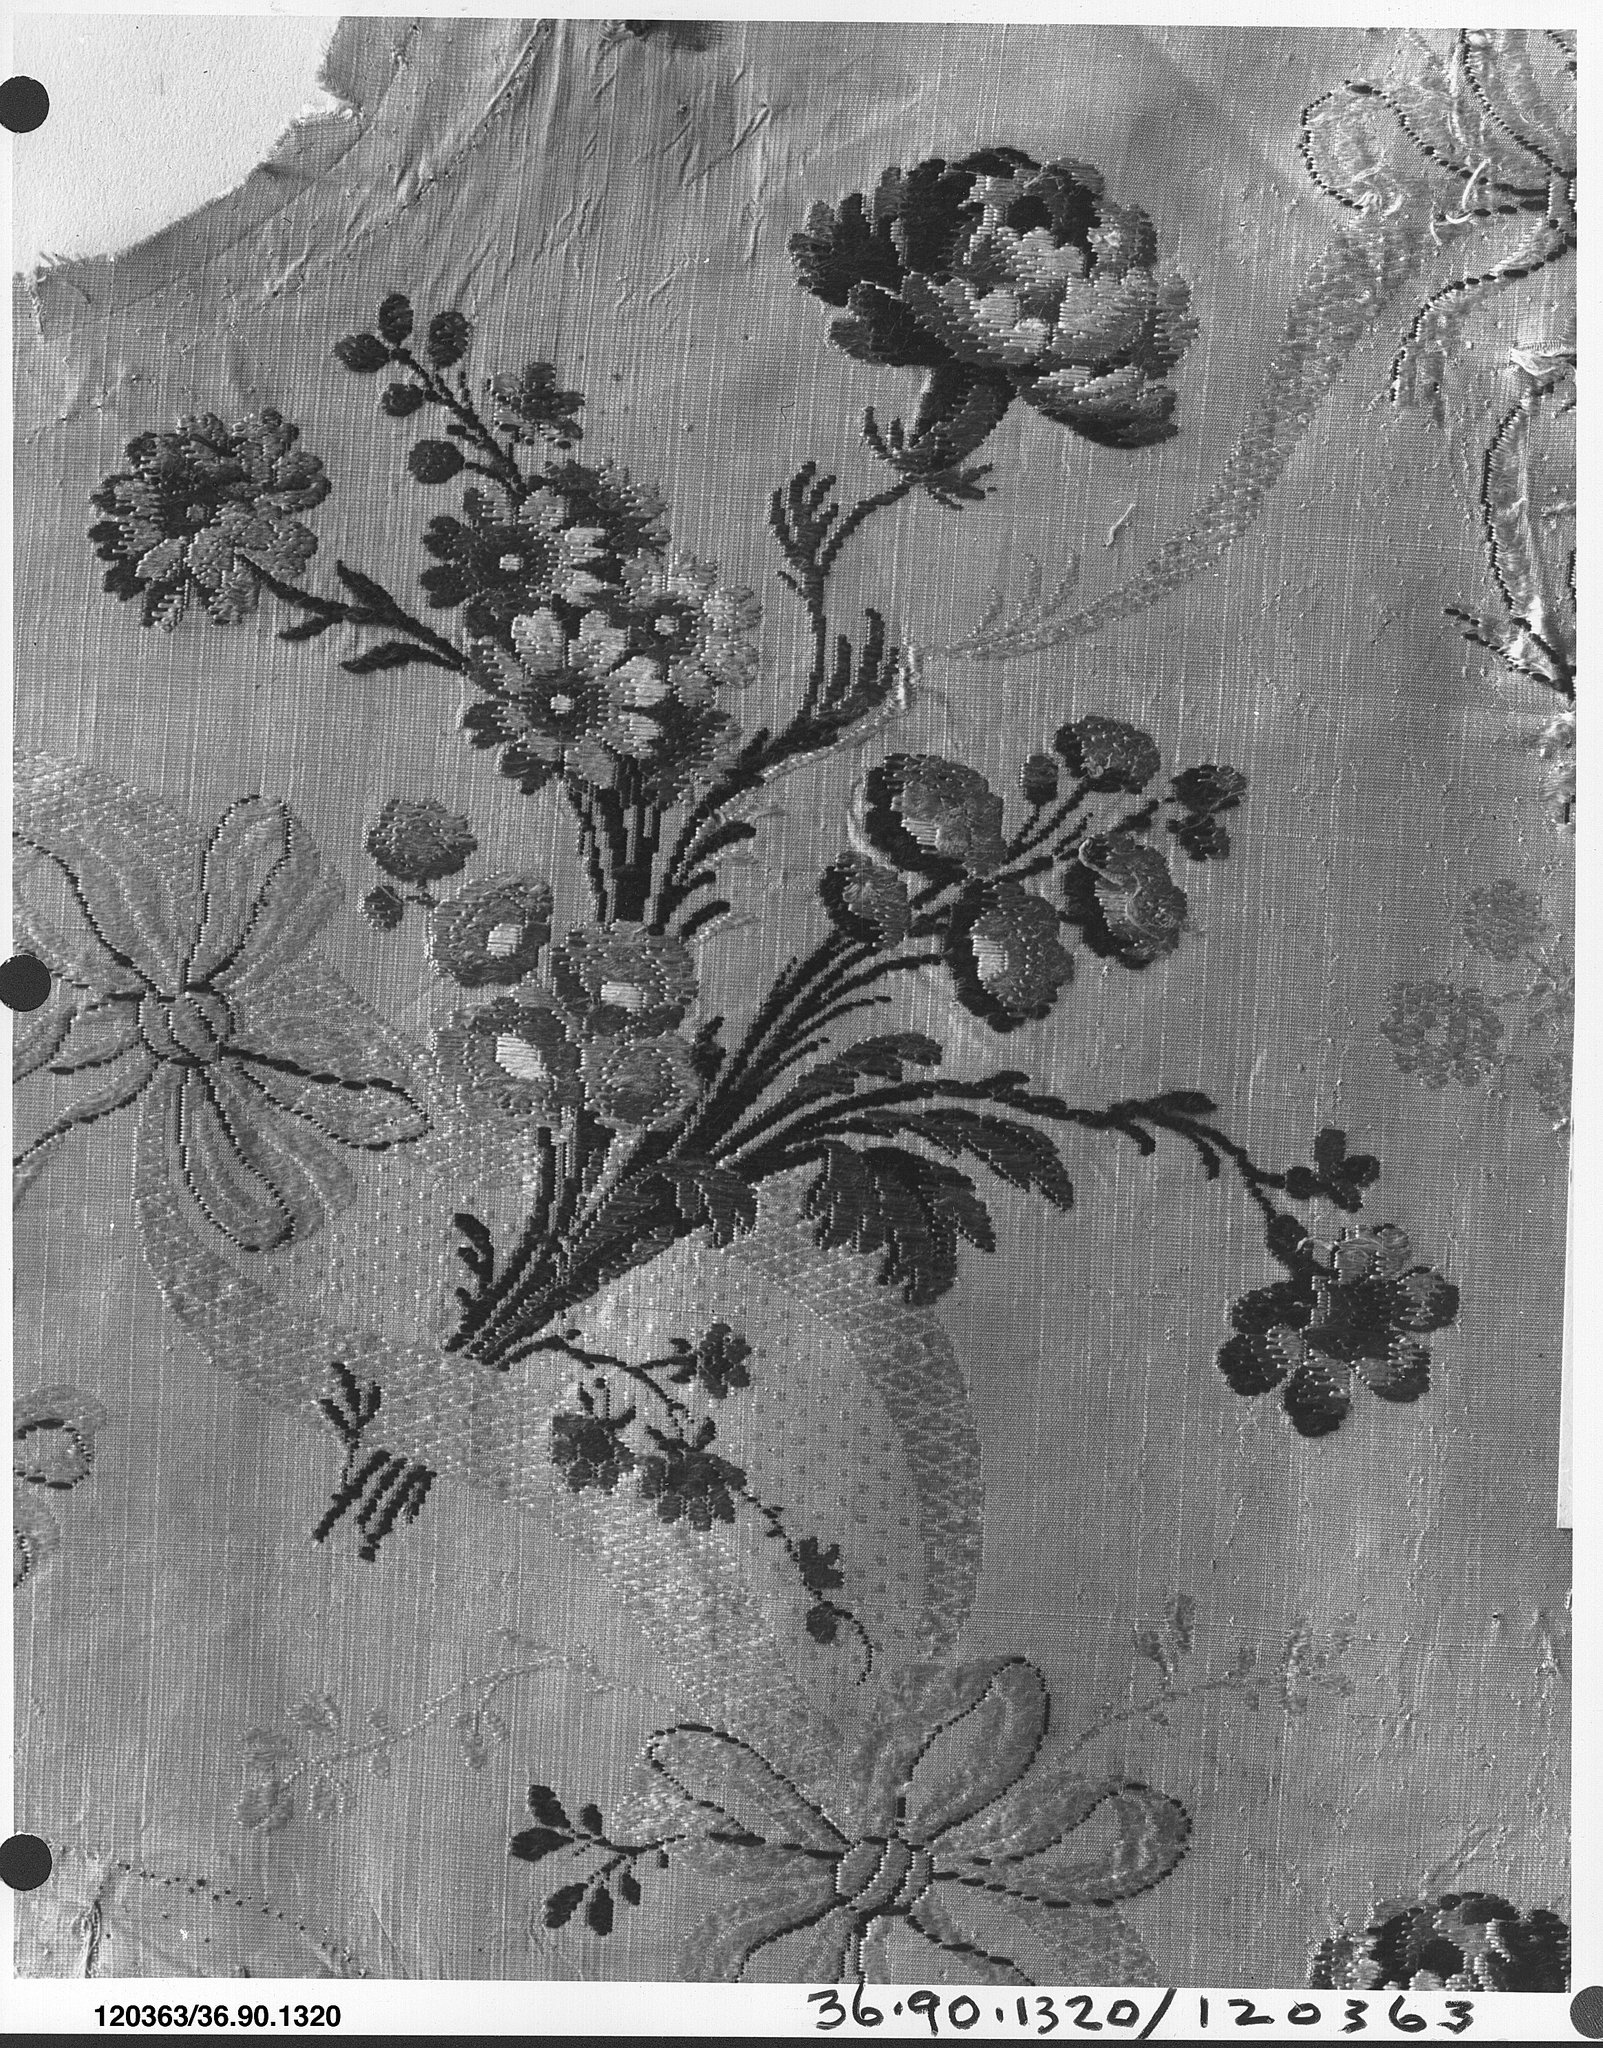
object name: piece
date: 1750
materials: silk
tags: flowers,leaves